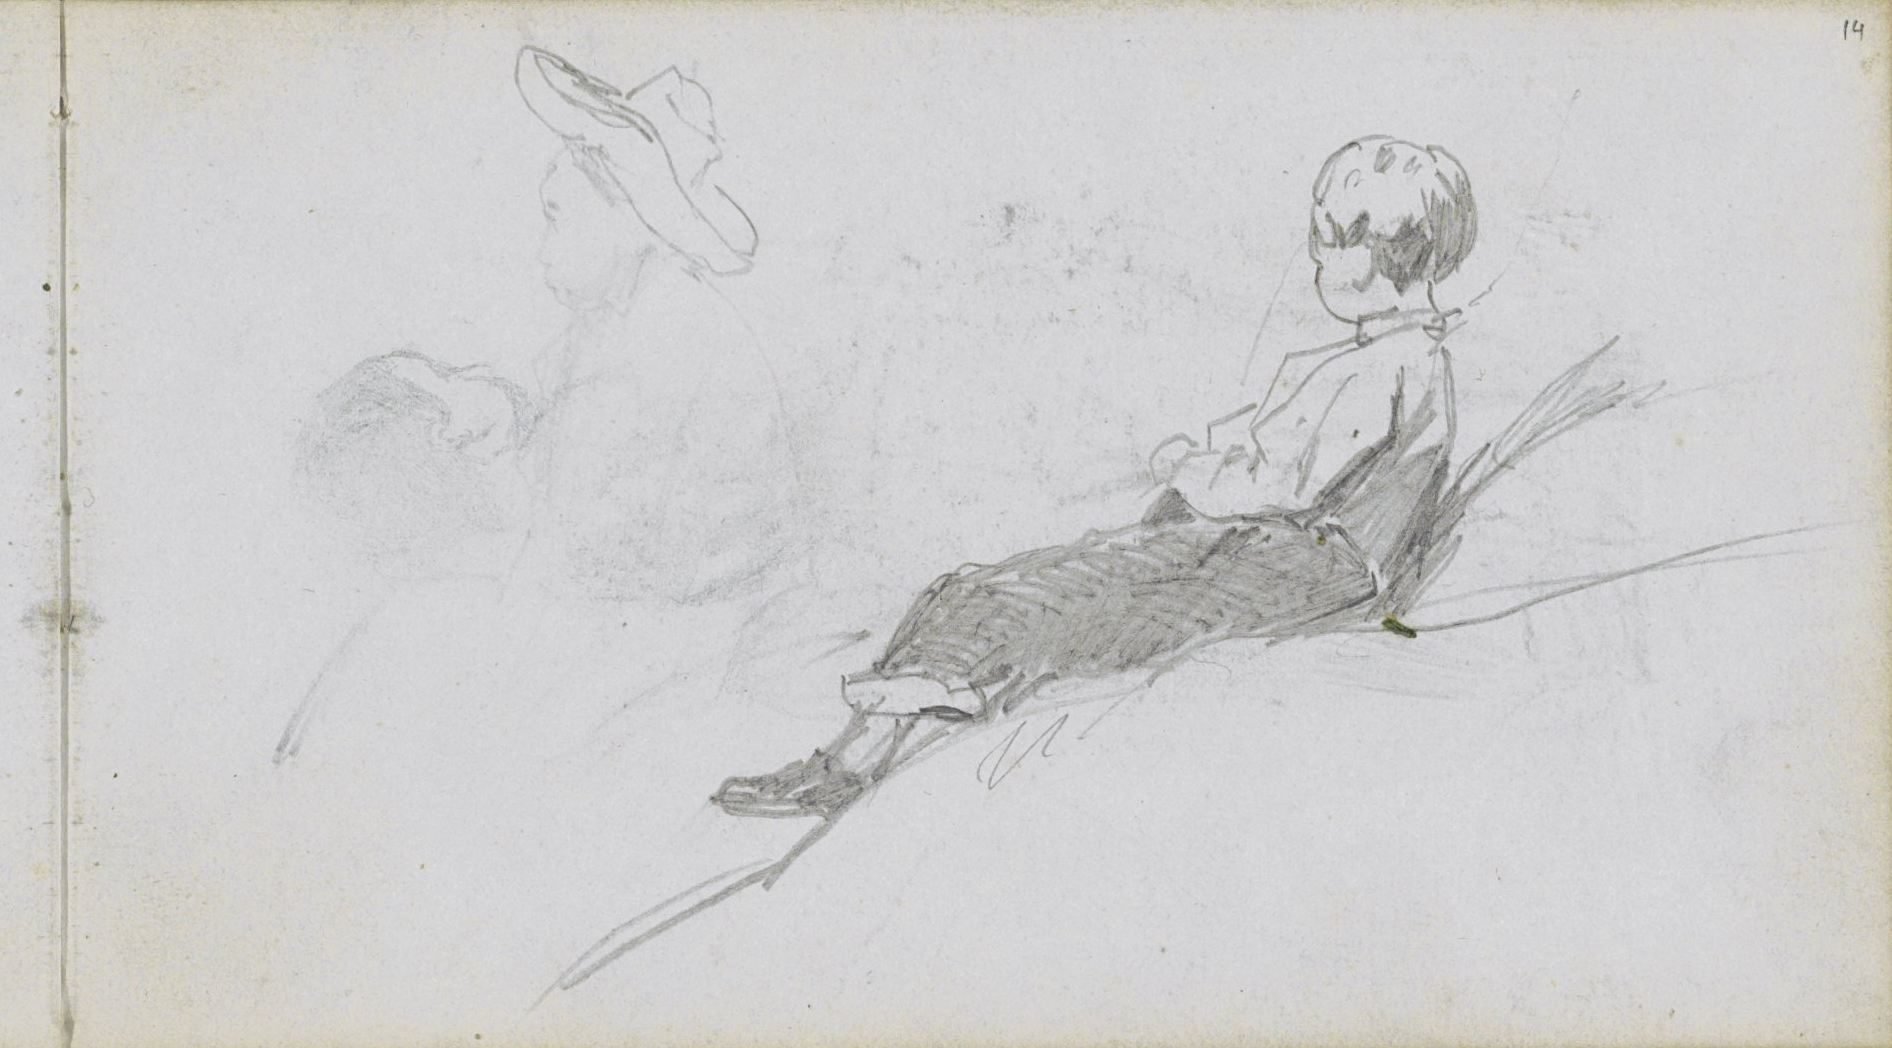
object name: sketchbook leaf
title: Jongen liggend op een heuvel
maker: johan hendrik weissenbruch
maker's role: draughtsman, painter, print maker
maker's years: 1824-1903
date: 1834-1903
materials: paper, pencil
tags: head (human), lying figure (+ young male (human being))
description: Tevens een studie van een man met een hoed. Blad 14 recto uit een schetsboek met 39 bladen.